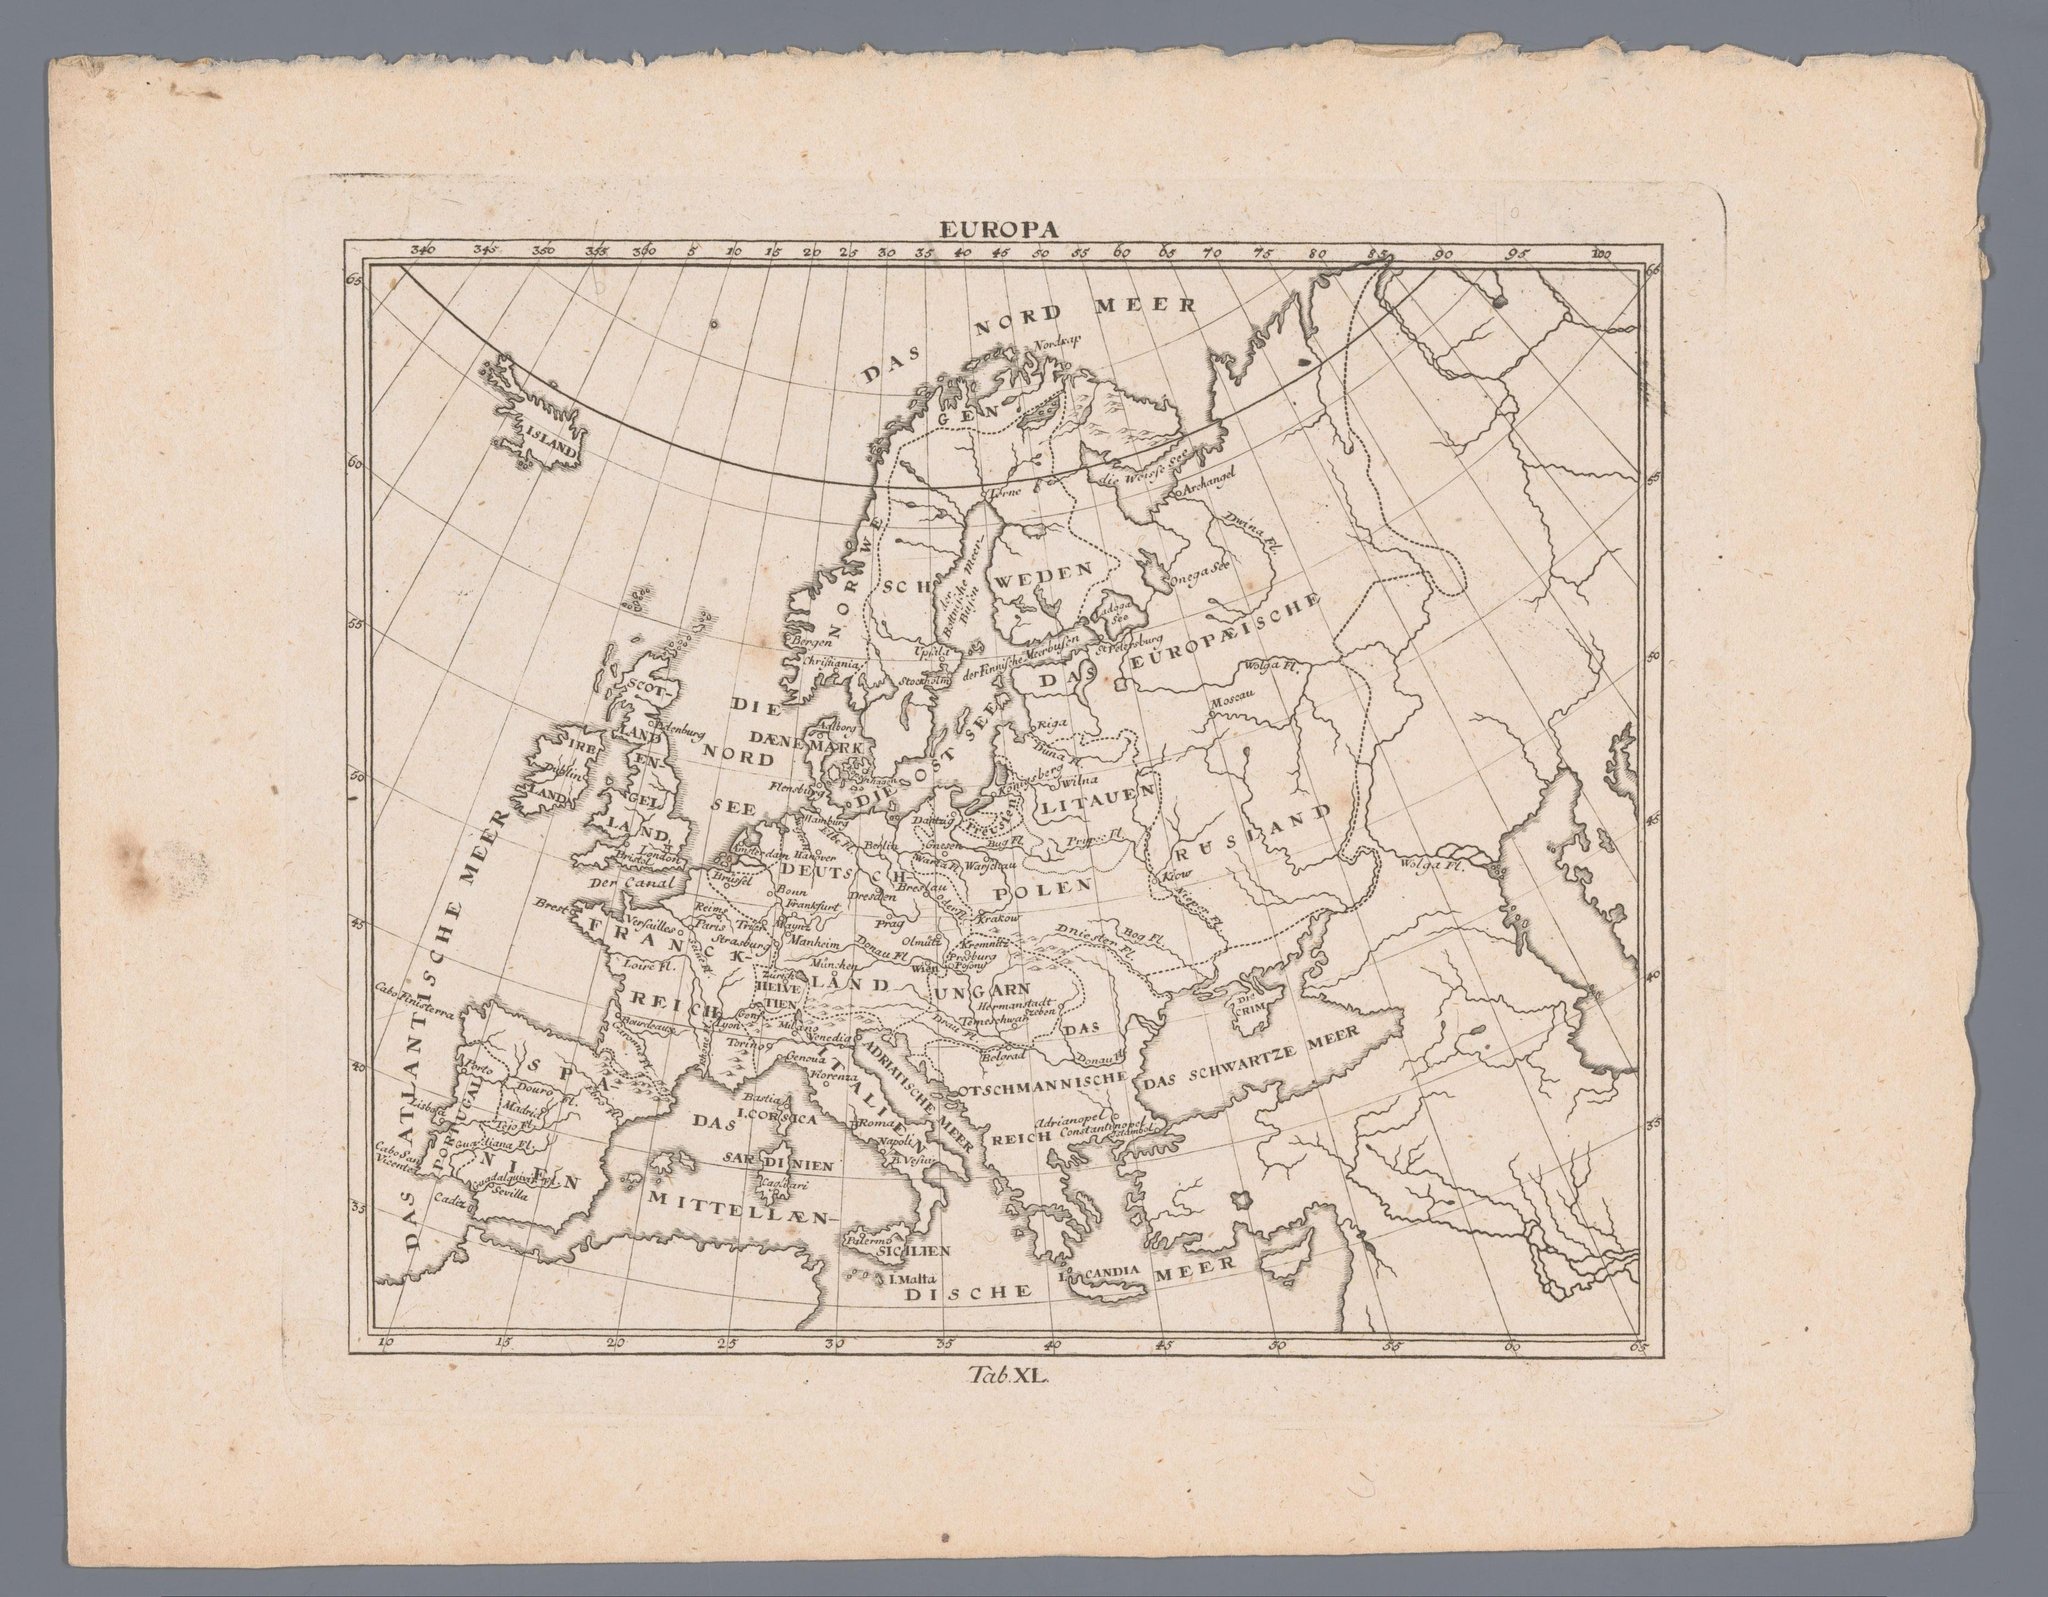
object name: print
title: Elementarische Landkarte von Europa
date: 1774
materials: paper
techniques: etching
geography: germany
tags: (map of) europe, europe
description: Prent ook gebruikt in: Basedow, Johann Bernhard. Das Basedowische Elementarwerk. Ein Vorrath der besten Erkenntnisse zum Lernen, Lehren, Wiederholen und Nachdenken. Leipzig: Siegfried Lebrecht Crucius, 1774.